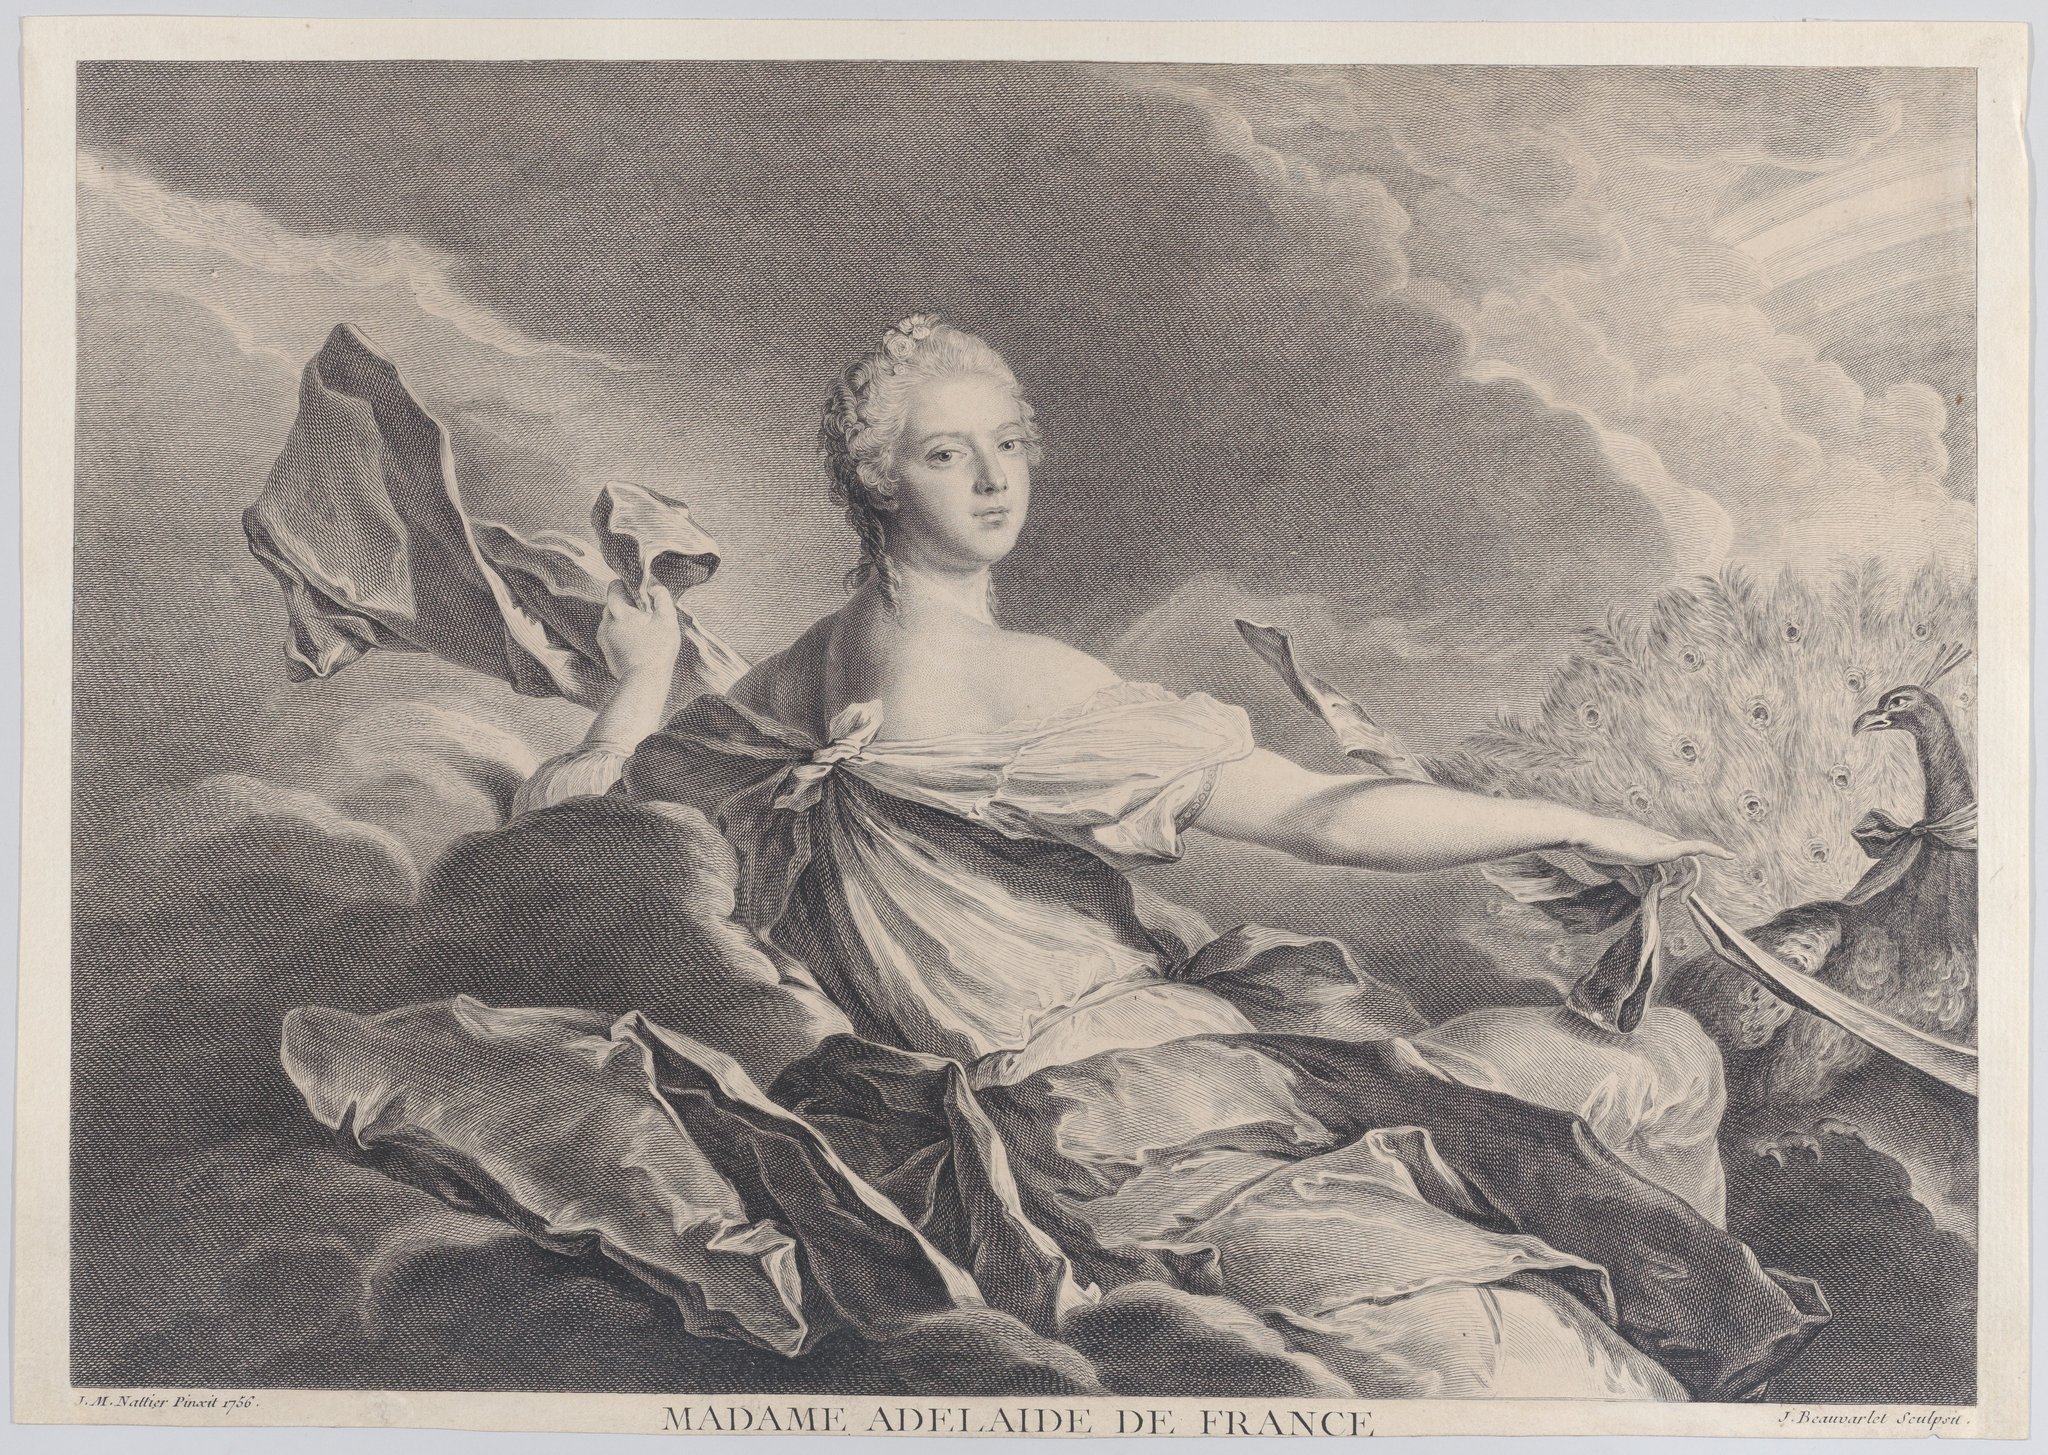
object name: print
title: Madame Adelaide de France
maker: jacques firmin beauvarlet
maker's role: artist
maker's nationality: french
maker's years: 1731-1797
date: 1756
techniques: engraving, etching